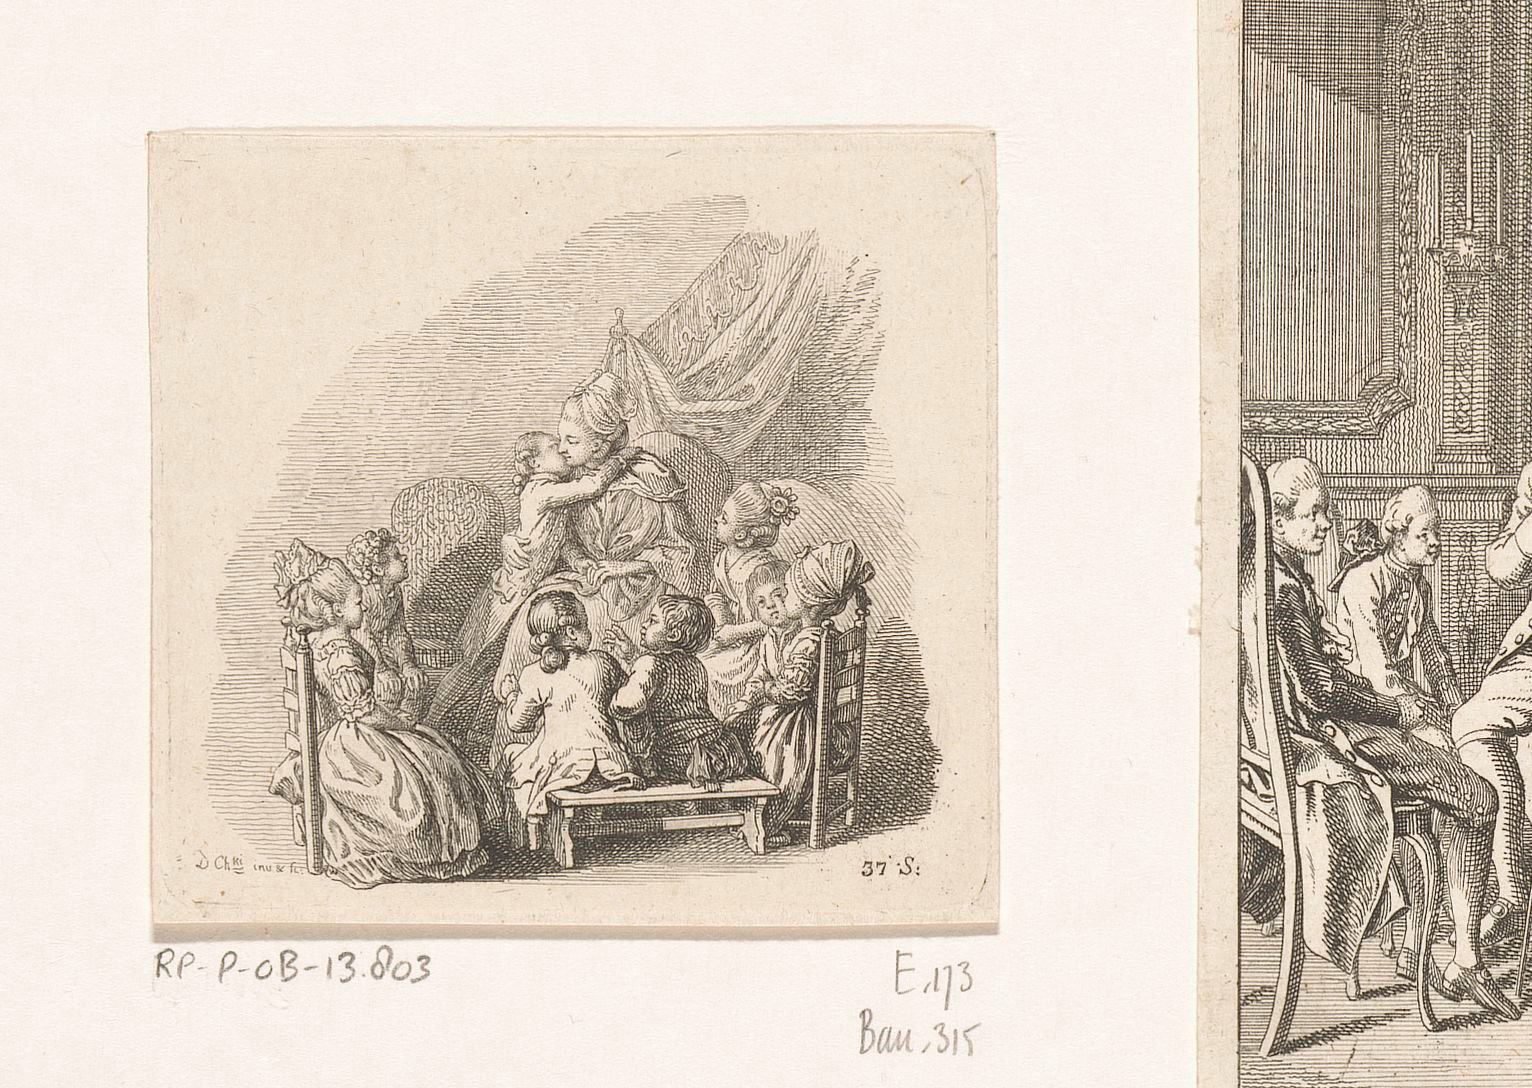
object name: print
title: Moeder met kinderen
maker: daniel nikolaus chodowiecki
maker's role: draughtsman, print maker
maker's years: 1726-1801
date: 1776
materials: paper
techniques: etching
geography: berlin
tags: children's games and plays, mother and child(ren), woman and child(ren) (family group)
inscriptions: collector's mark: Lugt 2228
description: Jongens en meisjes zitten in een kring rond hun moeder. Een jongen, Gustav, kust zijn moeder. Mogelijk wordt het 'Ringspiel' gespeeld.